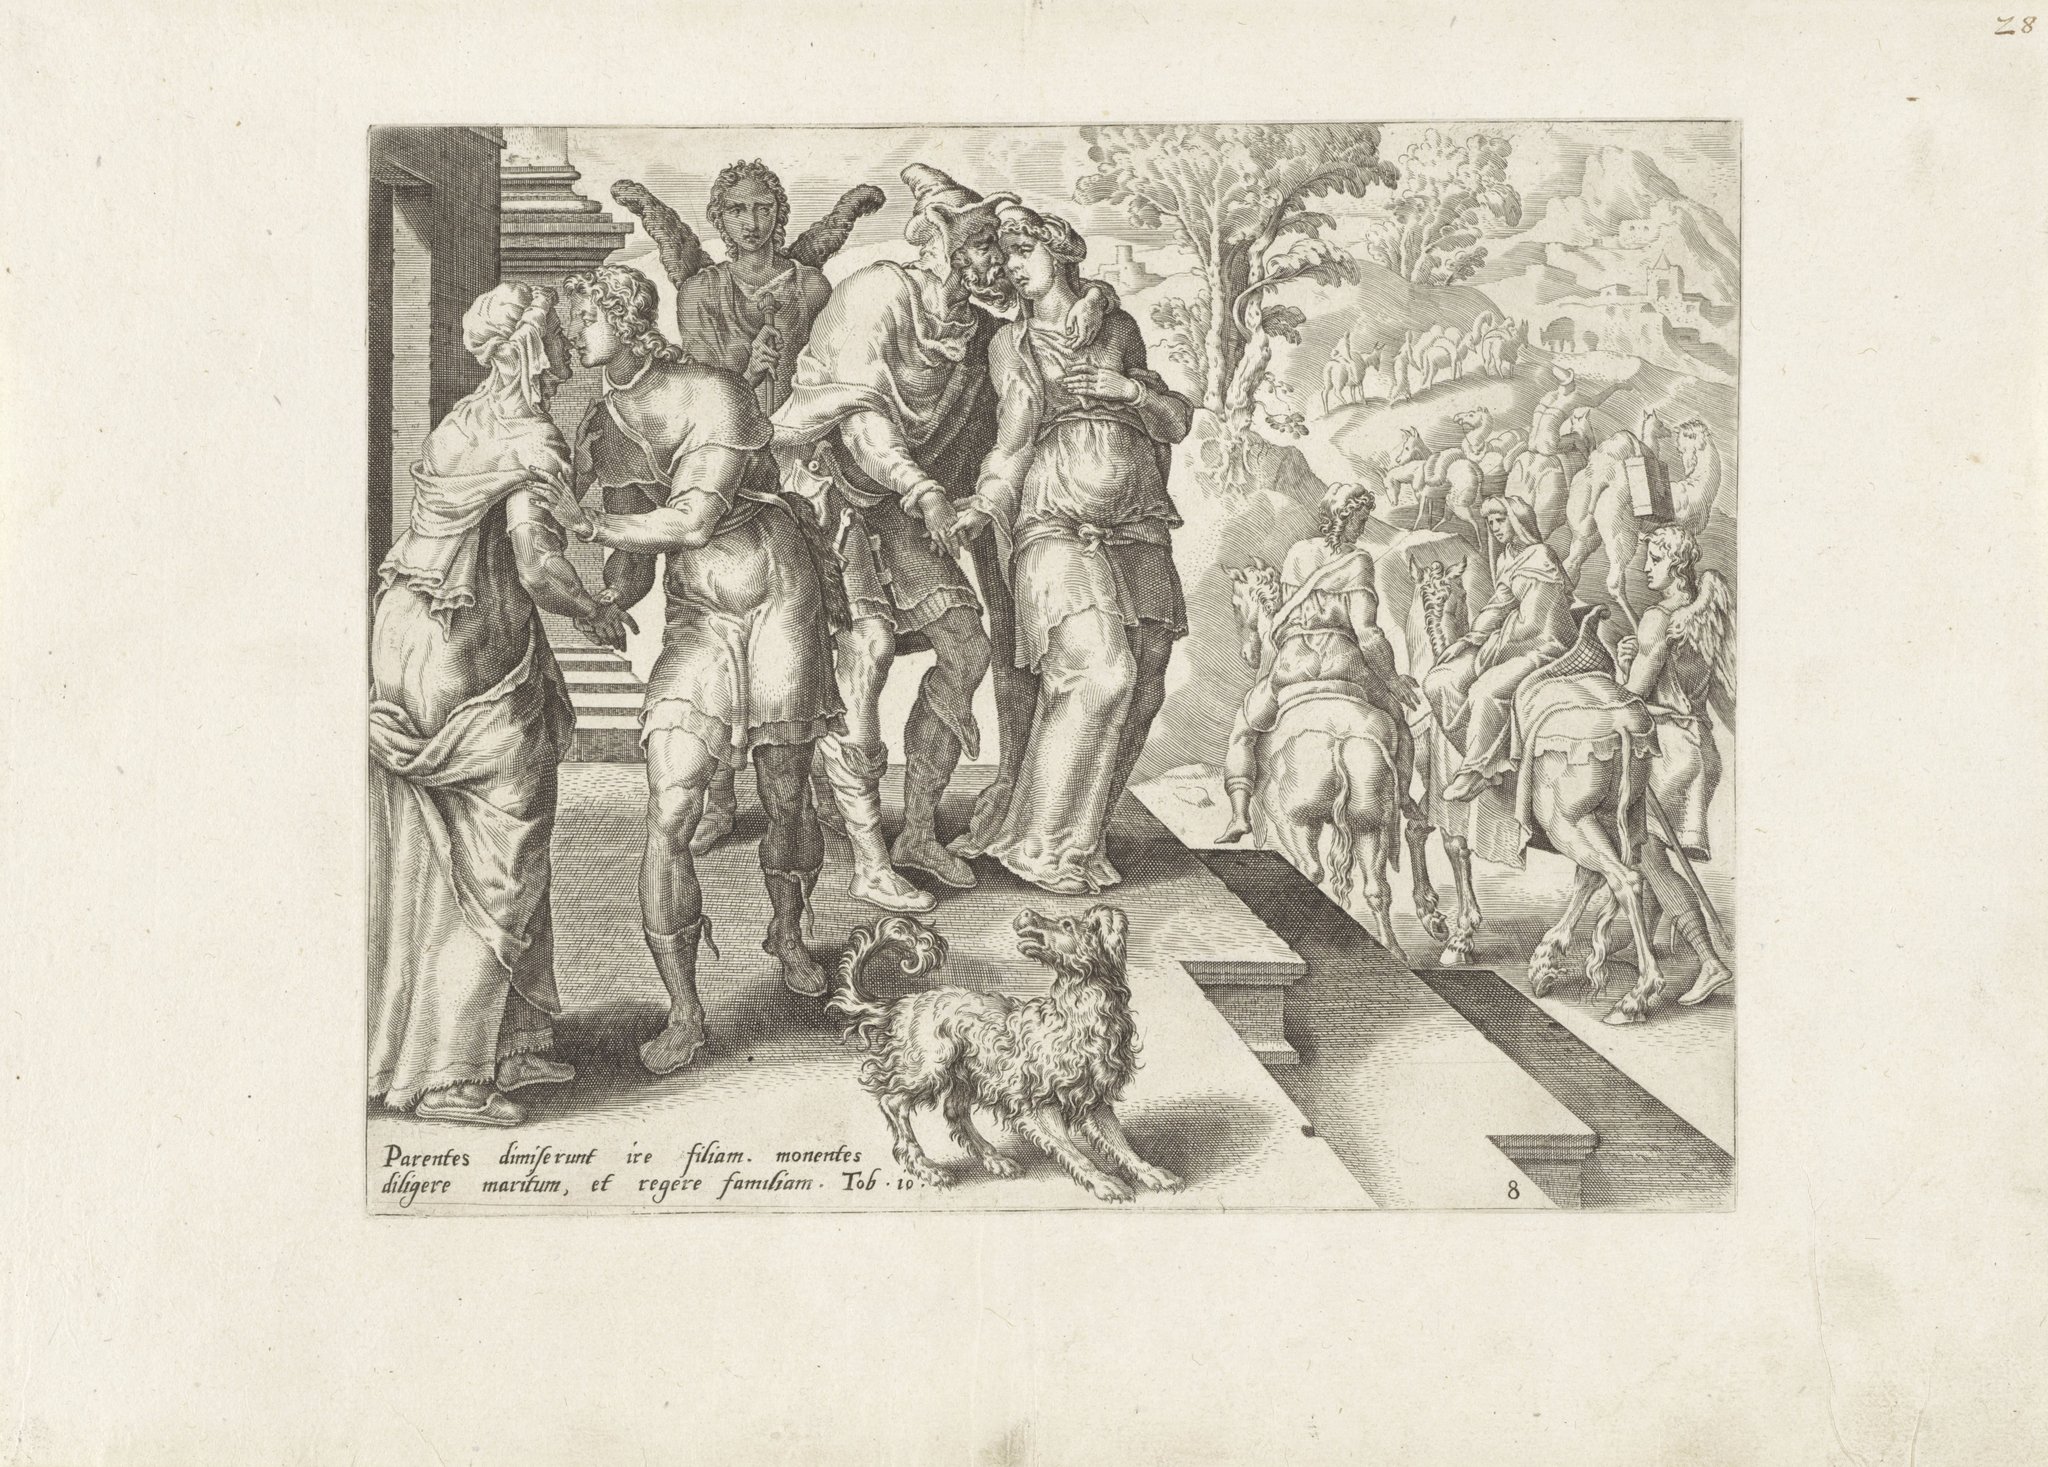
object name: print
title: Vertrek van Tobias en Sara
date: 1556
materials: paper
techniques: engraving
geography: antwerp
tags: the leave-taking ~ tobias' return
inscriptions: collector's mark: Lugt 2760, number: ‘28’, collector's mark: Lugt 2228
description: Sara neemt afscheid van Raguel en Tobias van Edna. De aartsengel Rafaël kijkt toe. Rechts vertrekken Tobias en Sara te paard met voor hen kamelen en ezels, die bepakt zijn met de helft van Raguels bezittingen als geschenk voor Tobias en zijn familie. Onderaan in de marge een éénregelig onderschrift in het Latijn uit Tobit 10.